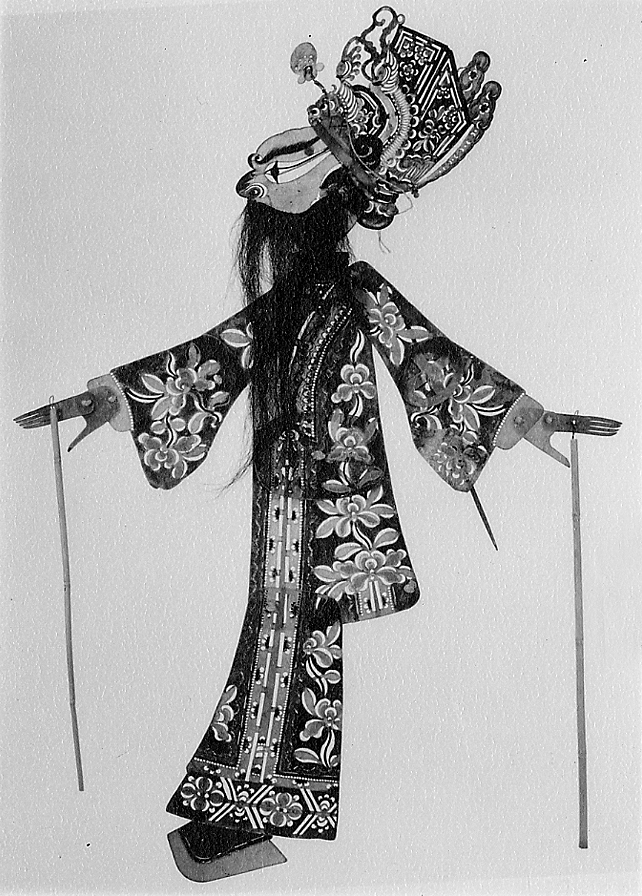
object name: shadow puppet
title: Scholar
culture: chinese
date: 1801-1900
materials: bamboo, cotton, hemp, metal, pigment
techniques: incising, painting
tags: men